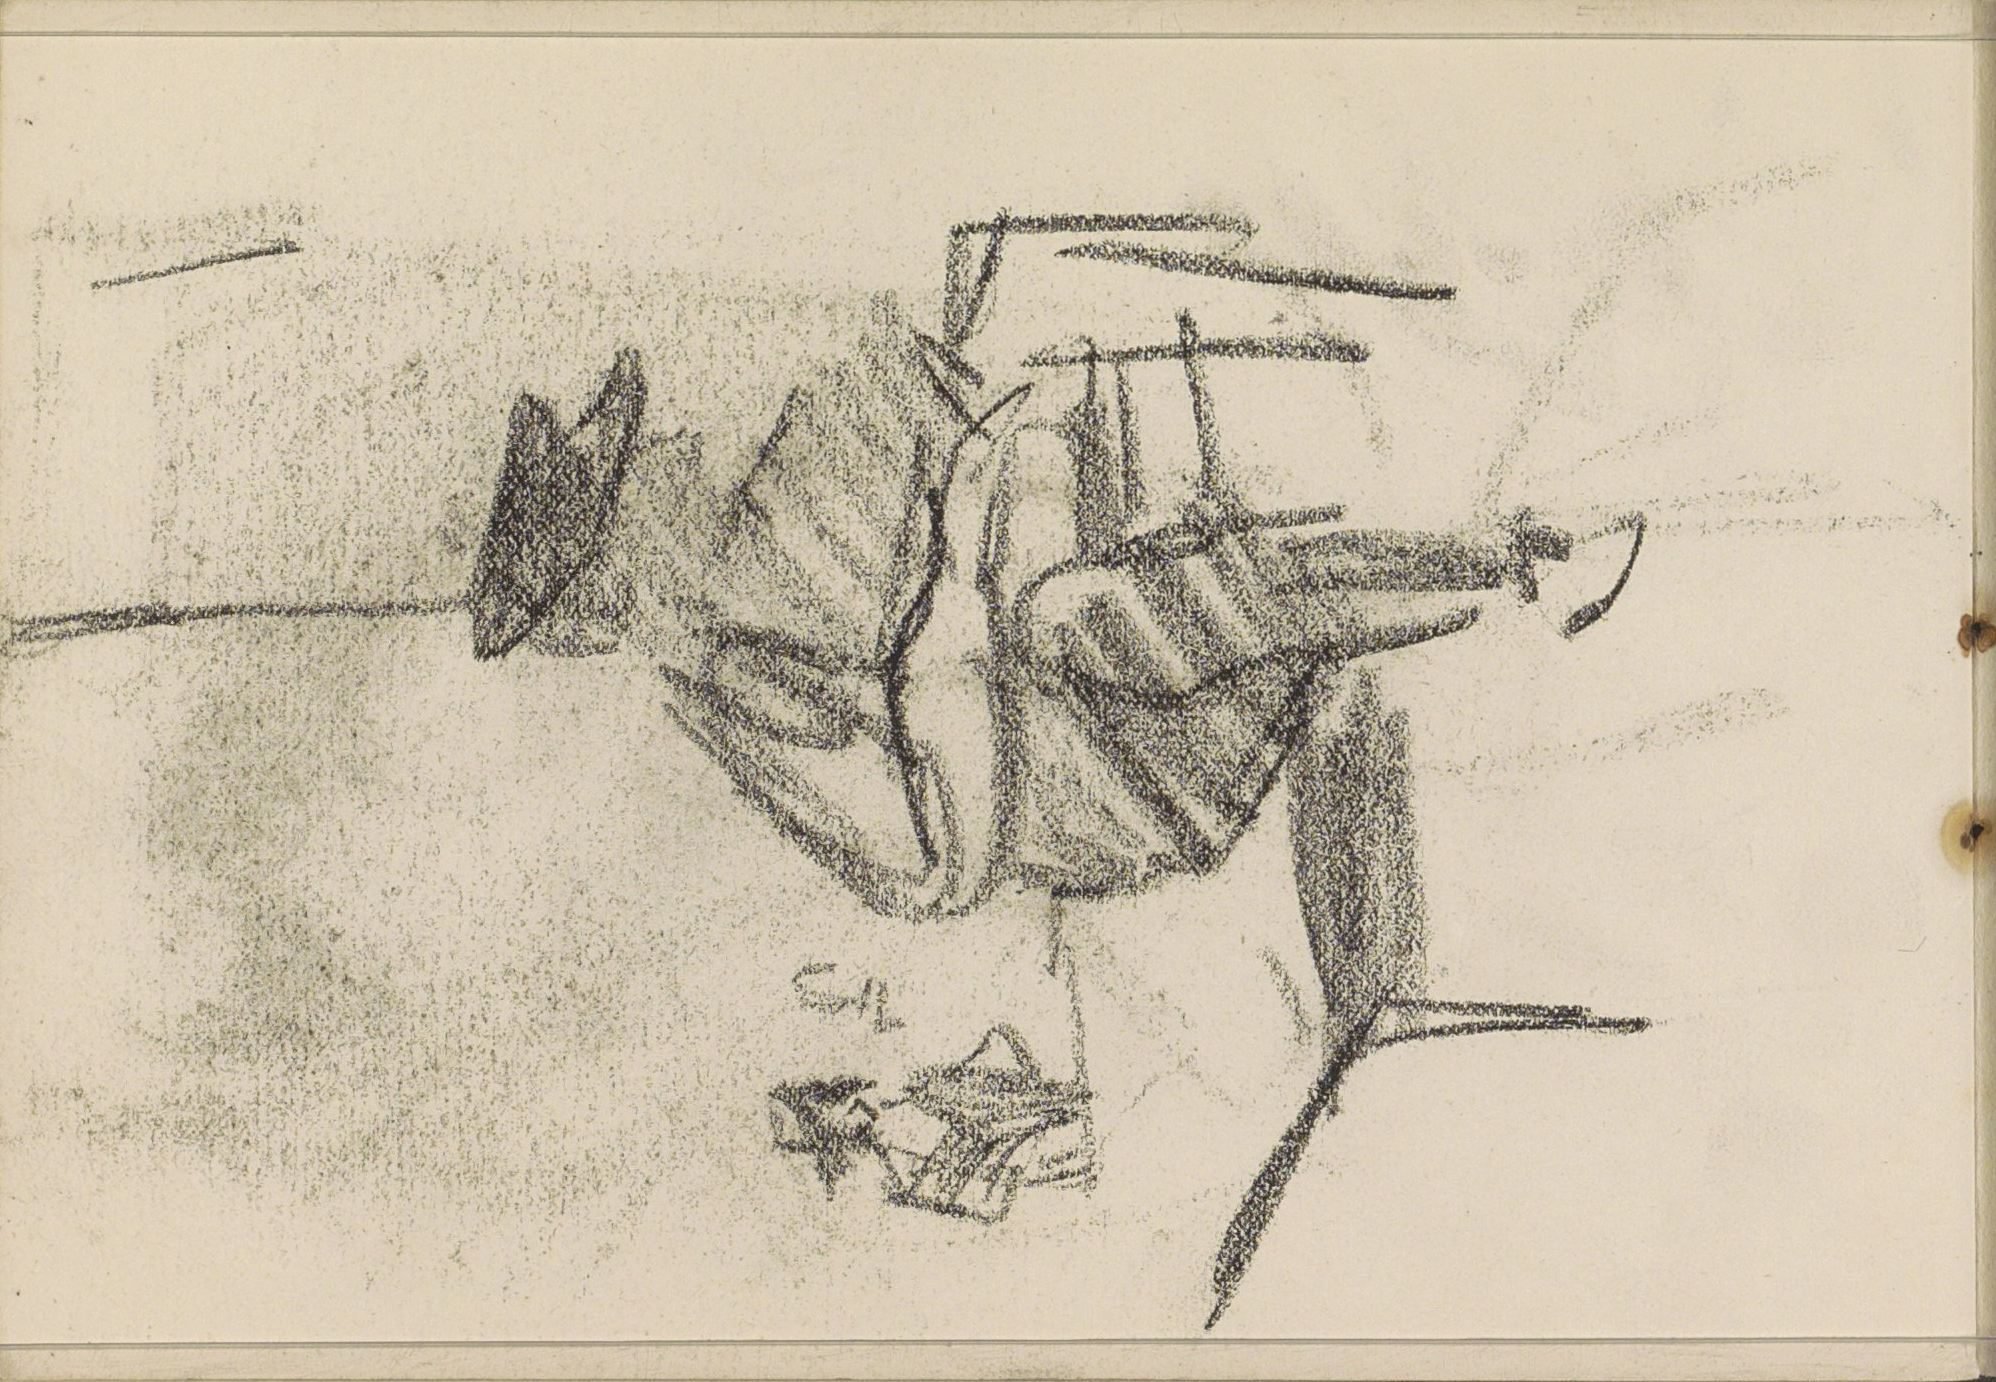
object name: sketchbook leaf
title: Zittende man met pet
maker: isaac israels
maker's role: draughtsman, painter, print maker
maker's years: 1865-1934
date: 1875-1934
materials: chalk, paper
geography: the hague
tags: adult man (+ sitting), head-gear: cap (+ men's clothes)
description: Op de achtergrond nog een figuur. Pagina 28 uit schetsboek XLII met 32 pagina's.